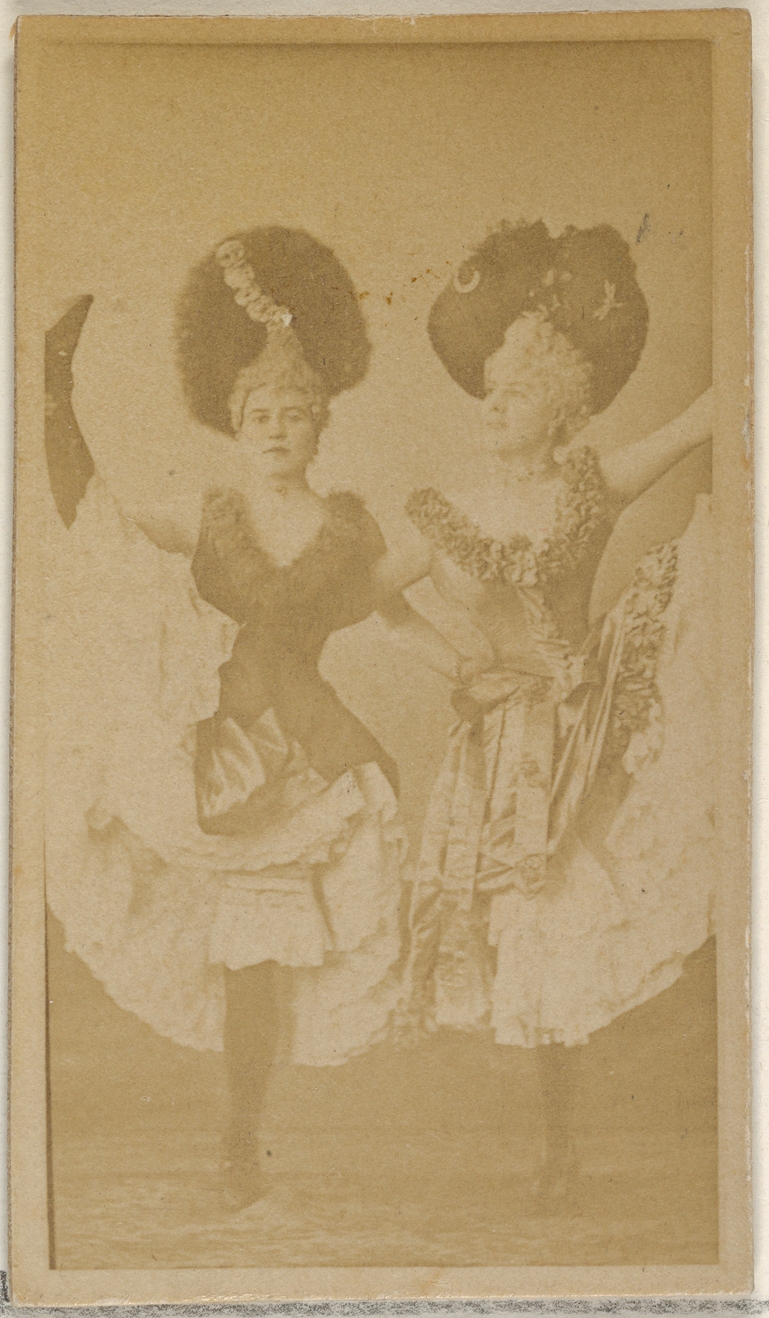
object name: photograph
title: From the Actors and Actresses series (N45, Type 8) for Virginia Brights Cigarettes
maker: allen & ginter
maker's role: publisher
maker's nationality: american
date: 1888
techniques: albumen silver print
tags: portraits,women,actresses